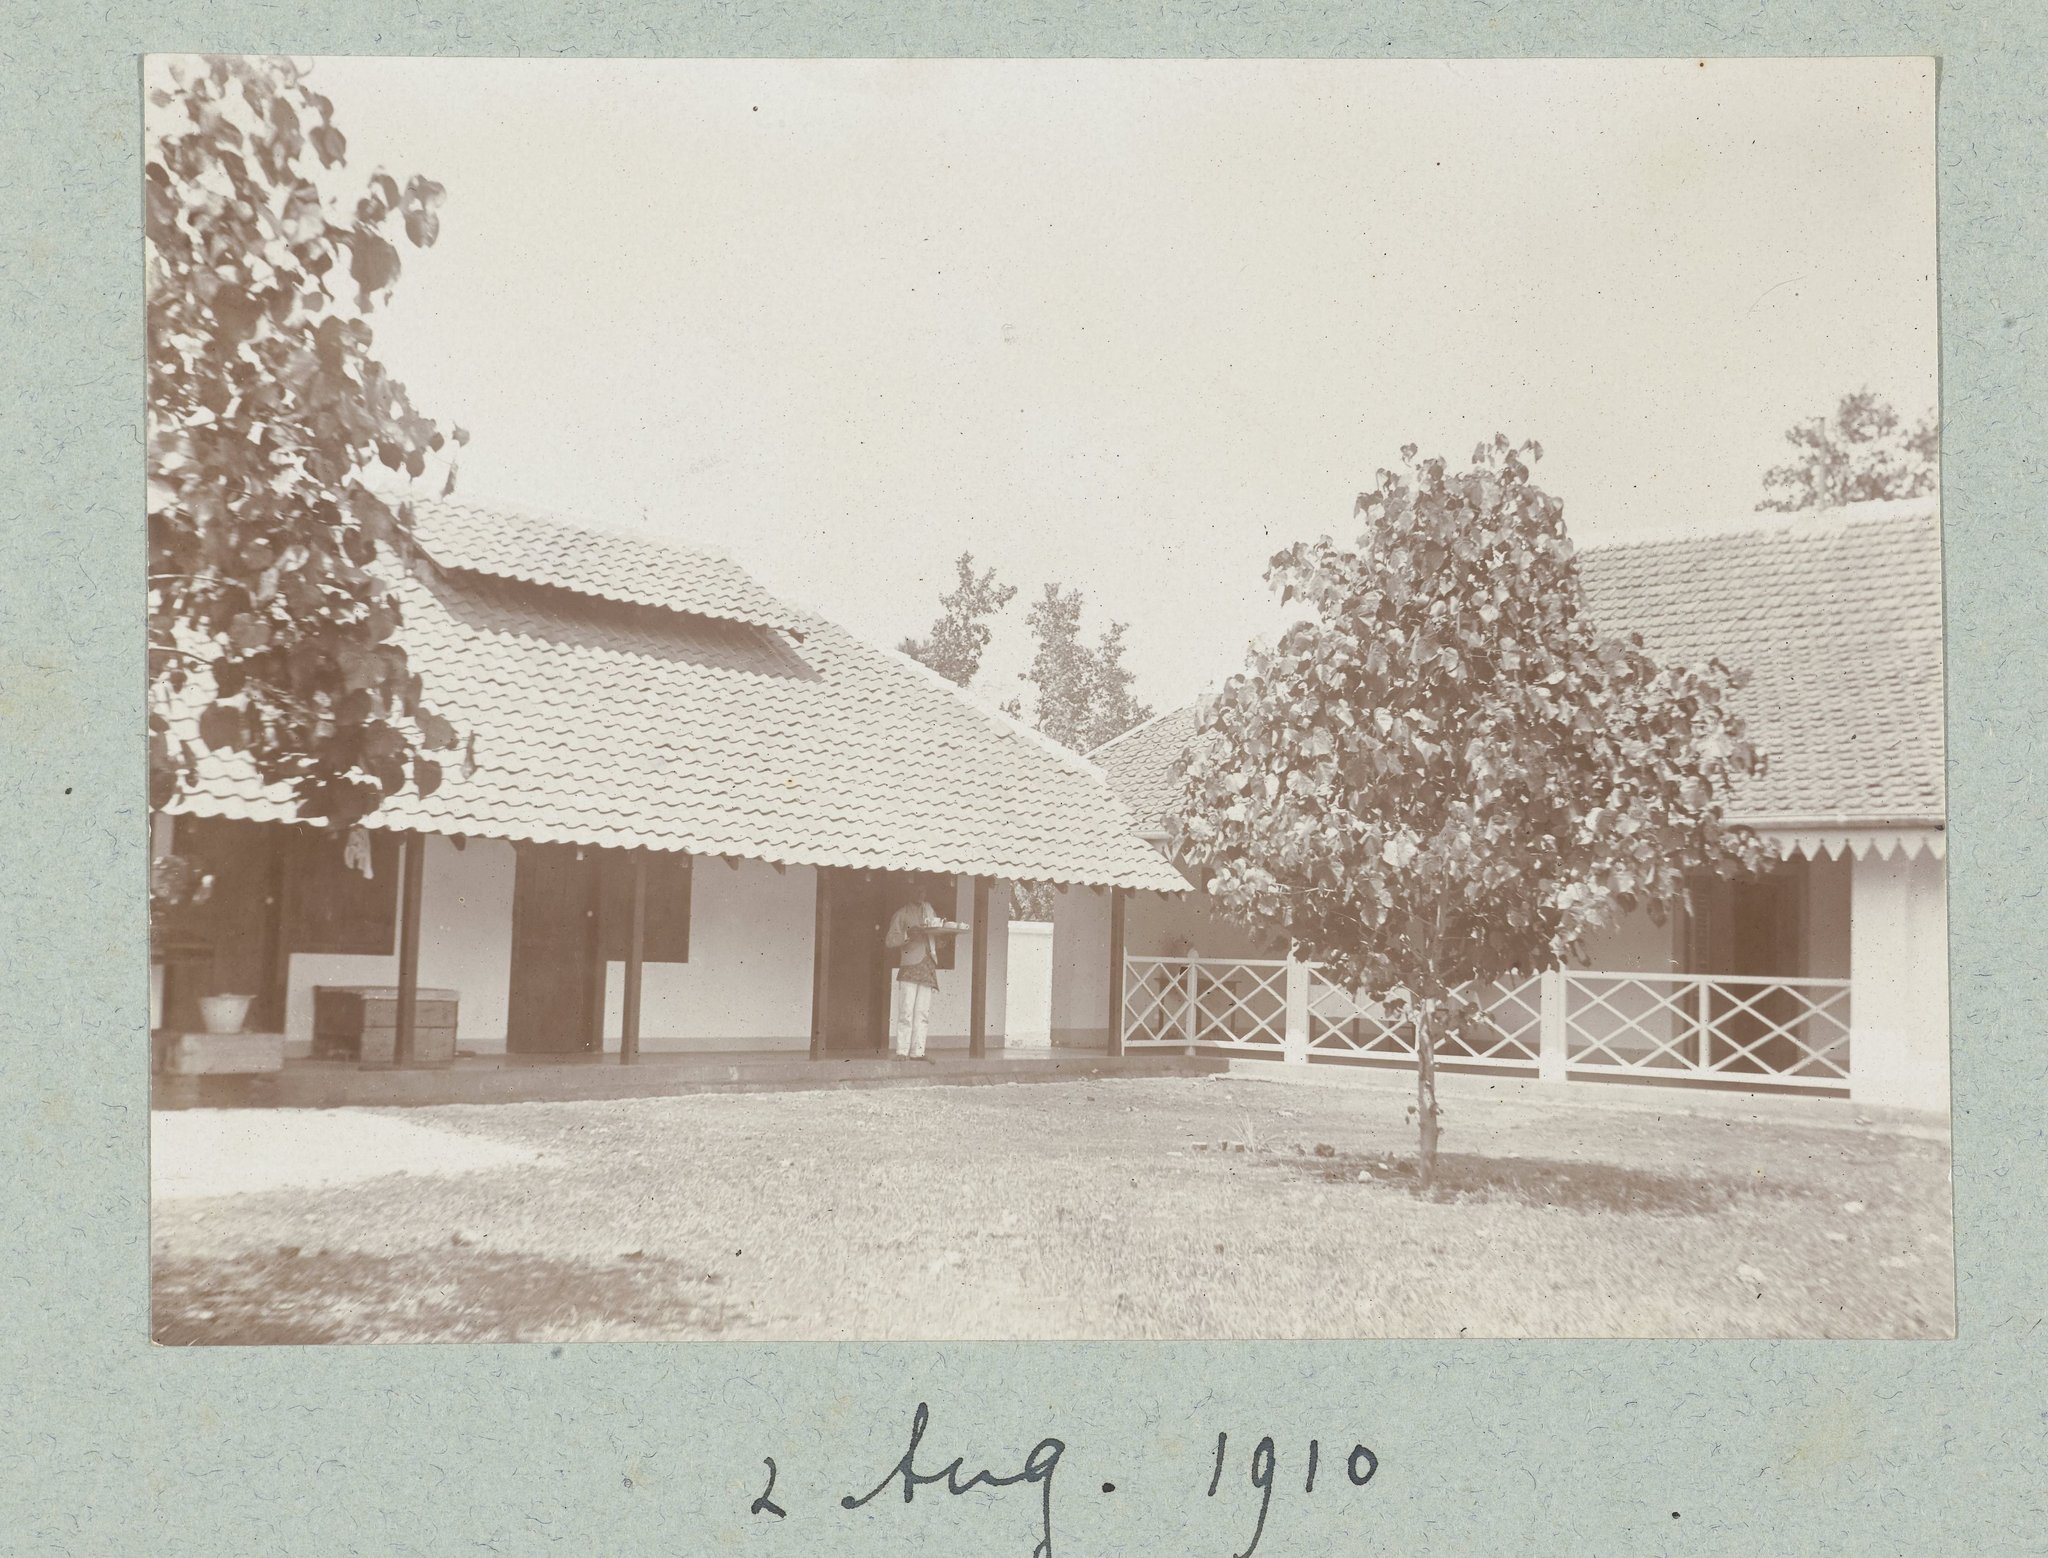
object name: photograph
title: Photographieën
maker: frits freerks fontein fz.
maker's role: fotograaf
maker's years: 1882-1928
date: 1903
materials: cardboard, paper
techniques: gelatin silver print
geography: madura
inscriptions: caption: ‘Kaliangel Madoera, 2 Aug. 1910’